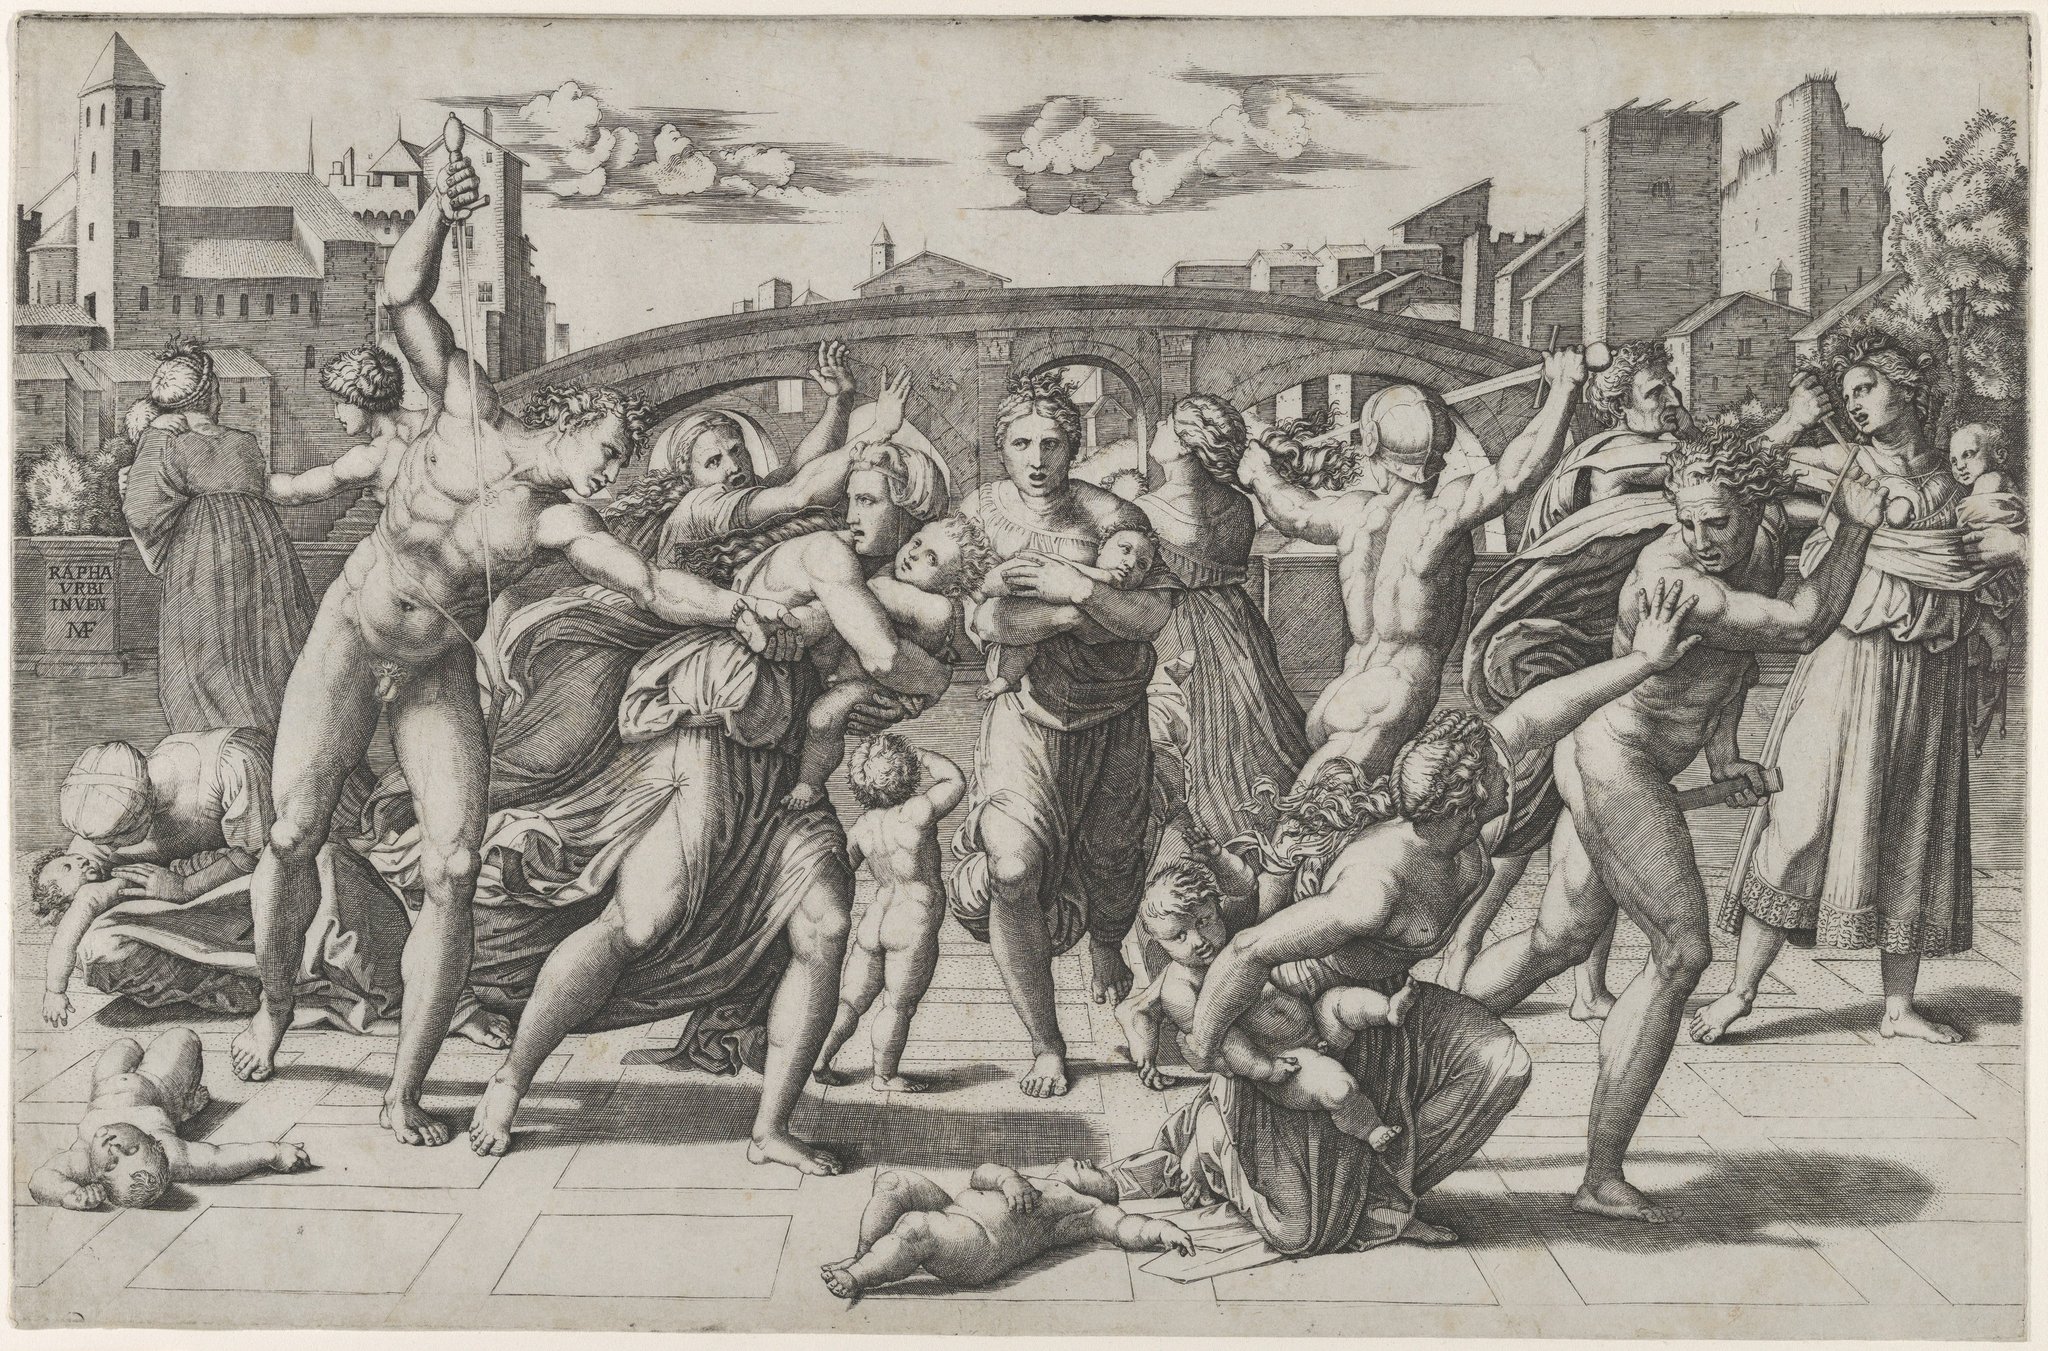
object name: print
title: The Massacre of the Innocents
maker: marcantonio raimondi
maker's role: artist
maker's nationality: italian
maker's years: 1475-1534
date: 1512-1513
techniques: engraving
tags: massacres,suffering,children,men,male nudes,women